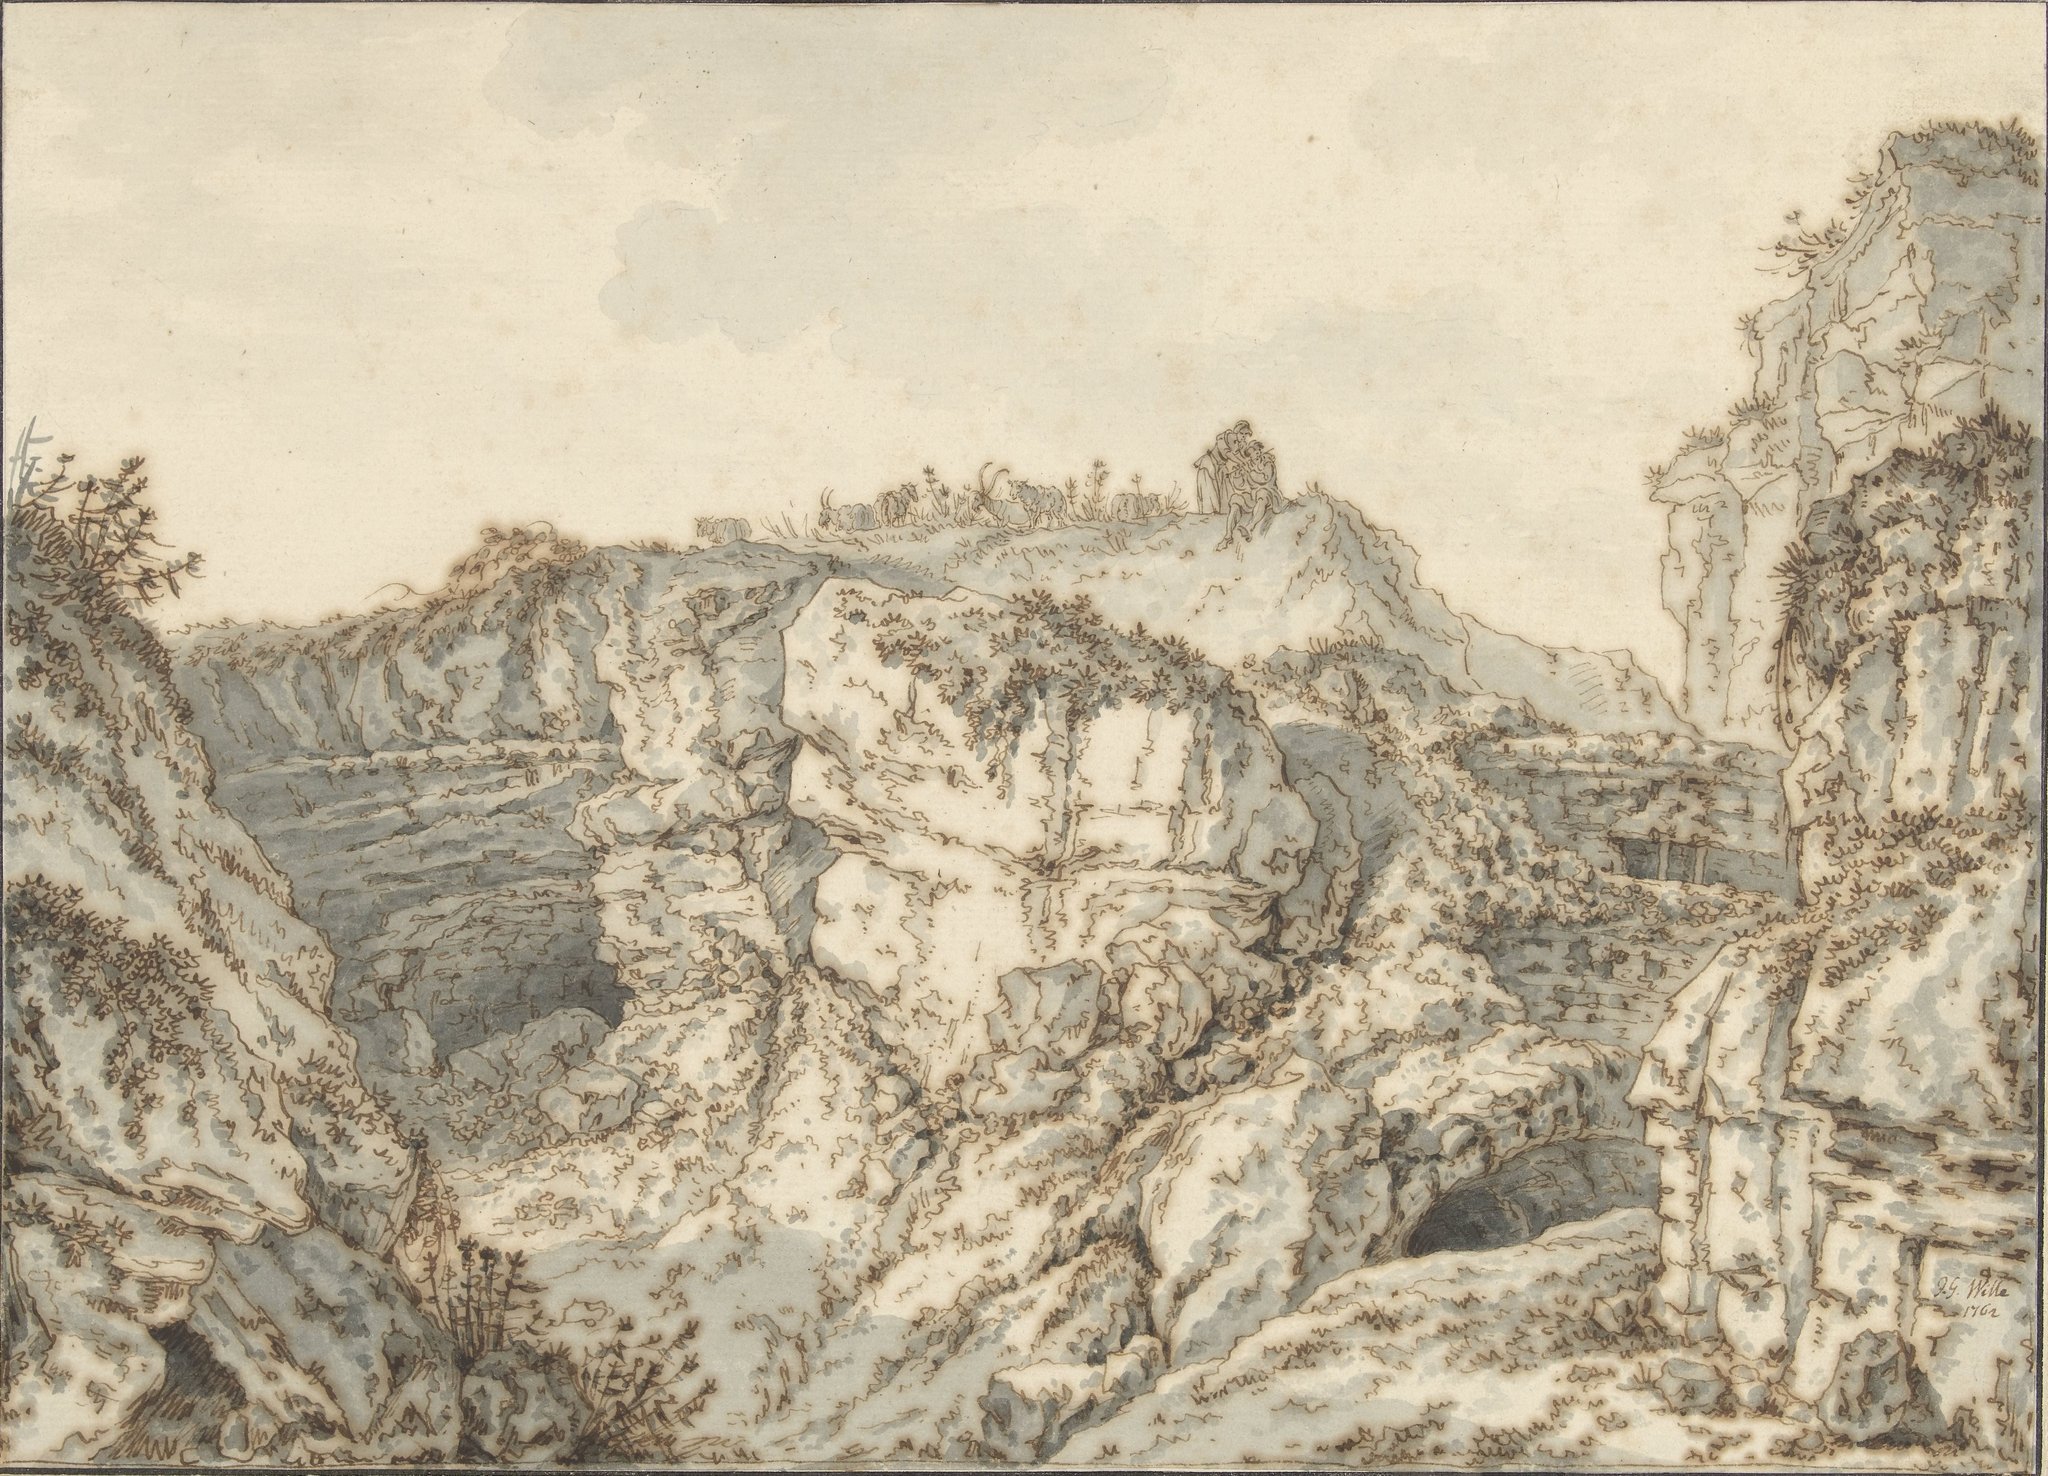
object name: drawing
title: Rotspartij op Montmartre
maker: johann georg wille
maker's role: draughtsman, print maker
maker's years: 1715-1808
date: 1762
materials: ink, paper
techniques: brush, pen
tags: rocks